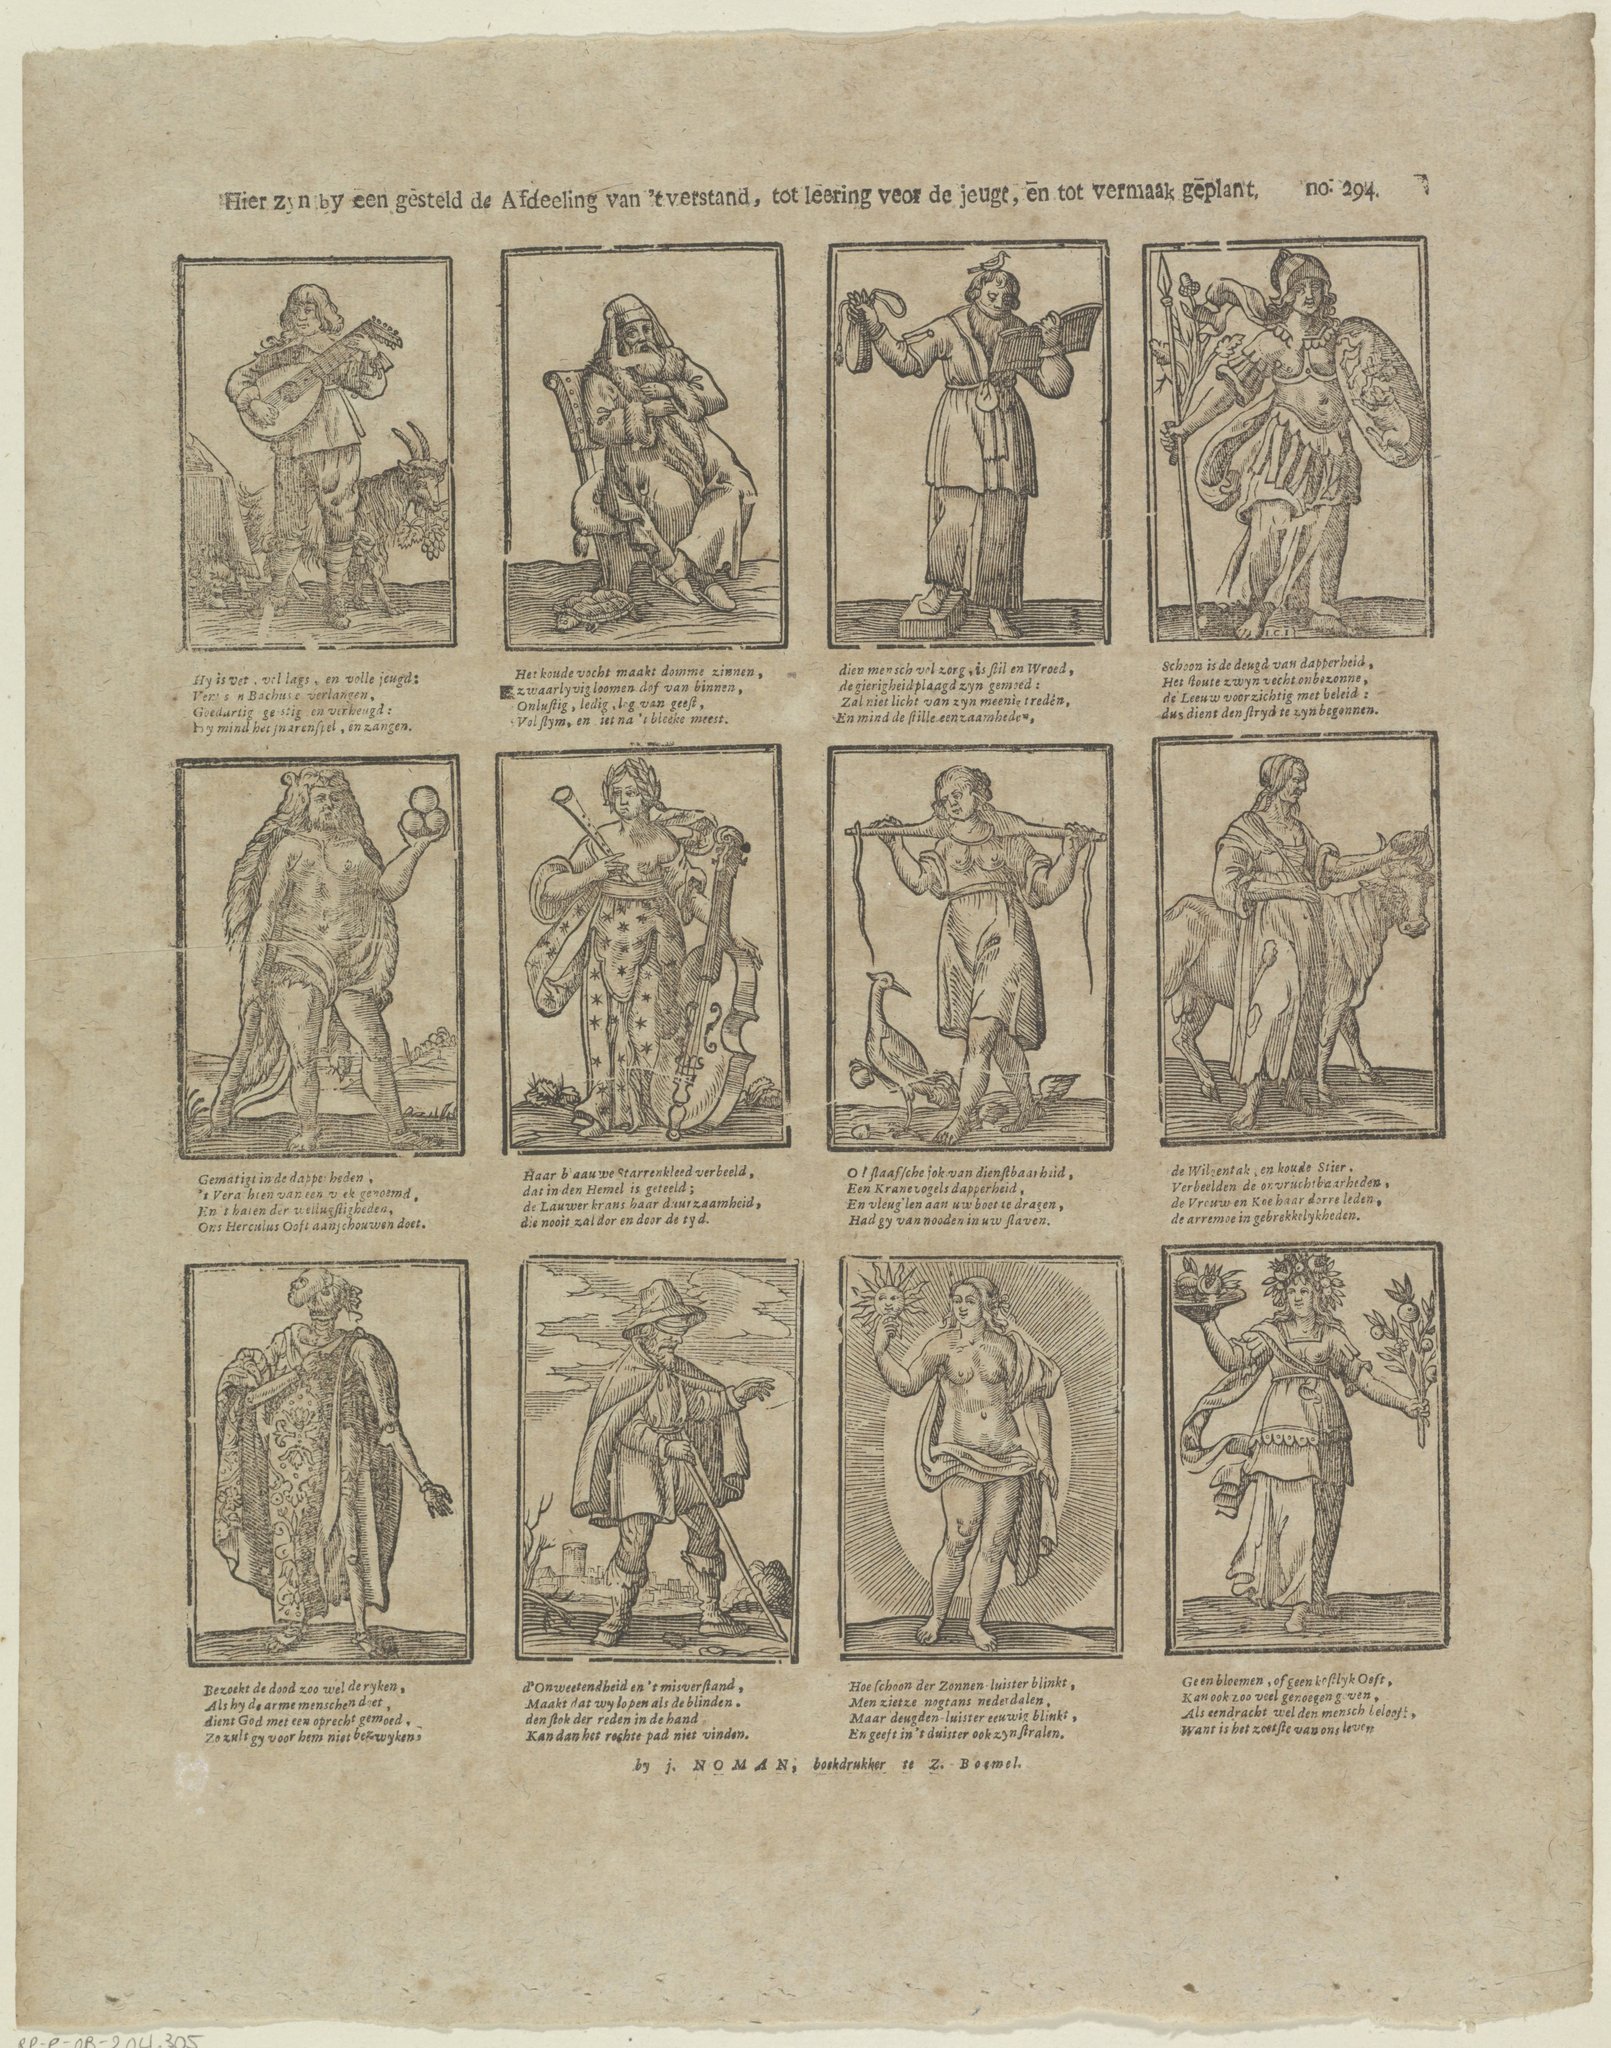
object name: print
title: Hier zyn by een gesteld de afdeeling van 't verstand, tot leering voor de jeugt, en tot vermaak geplant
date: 1806-1830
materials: paper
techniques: letterpress printing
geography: zaltbommel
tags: subordination (+ emblematical representation of concept), personifications of death; 'morte' (ripa), symbolic representations, allegories and emblems ~ art; 'arte' (ripa), ignorance; 'ignoranza', 'ignoranza di tutte le cose', 'ignoranza in un ricco senza lettere' (ripa), courage, bravery, valiance, manliness; 'ardire magnanimo et generoso', 'gagliardezza', 'valore', 'virtù heroica', 'virtù dell'animo e del corpo' (ripa)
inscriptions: collector's mark: Lugt 2760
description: Blad met 12 voorstellingen van emblemata, waaronder verbeeldingen van dapperheid, dienstbaarheid en onwetendheid. Onder elke afbeelding een vierregelig vers. Genummerd rechtsboven: no. 294.